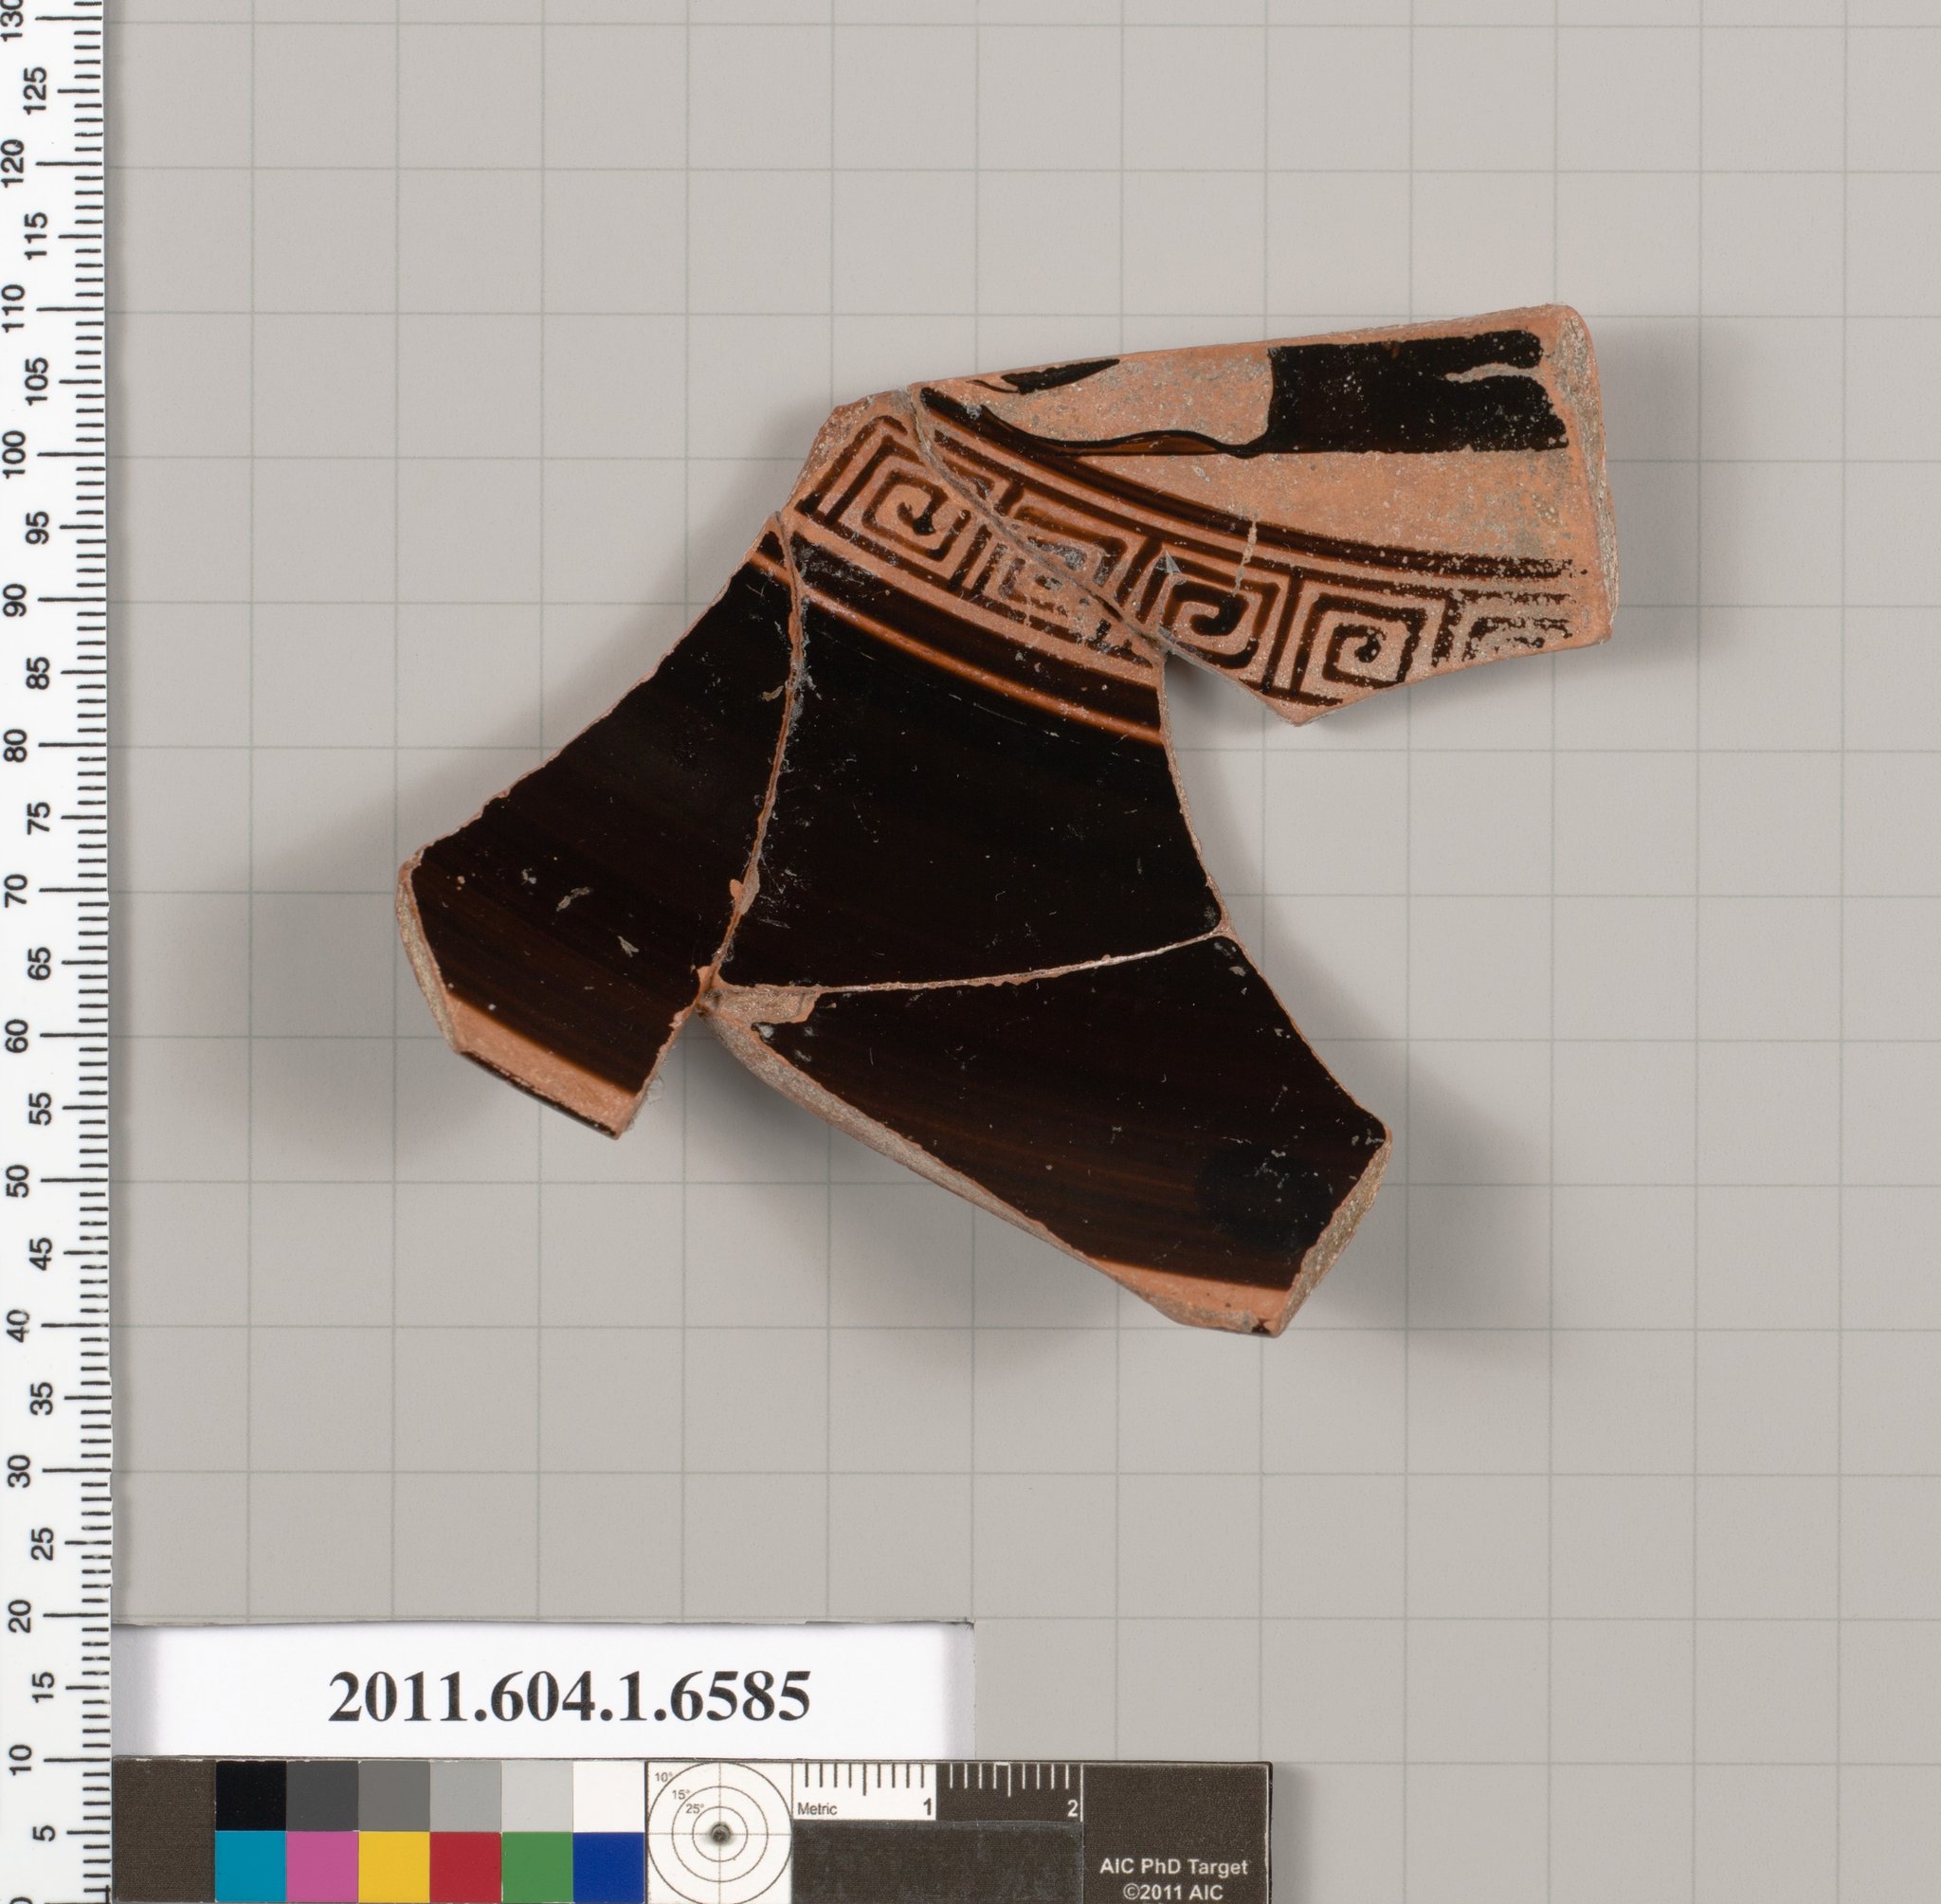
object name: kylix fragment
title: Terracotta fragment of a kylix (drinking cup)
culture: greek, attic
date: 490-480 BCE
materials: terracotta